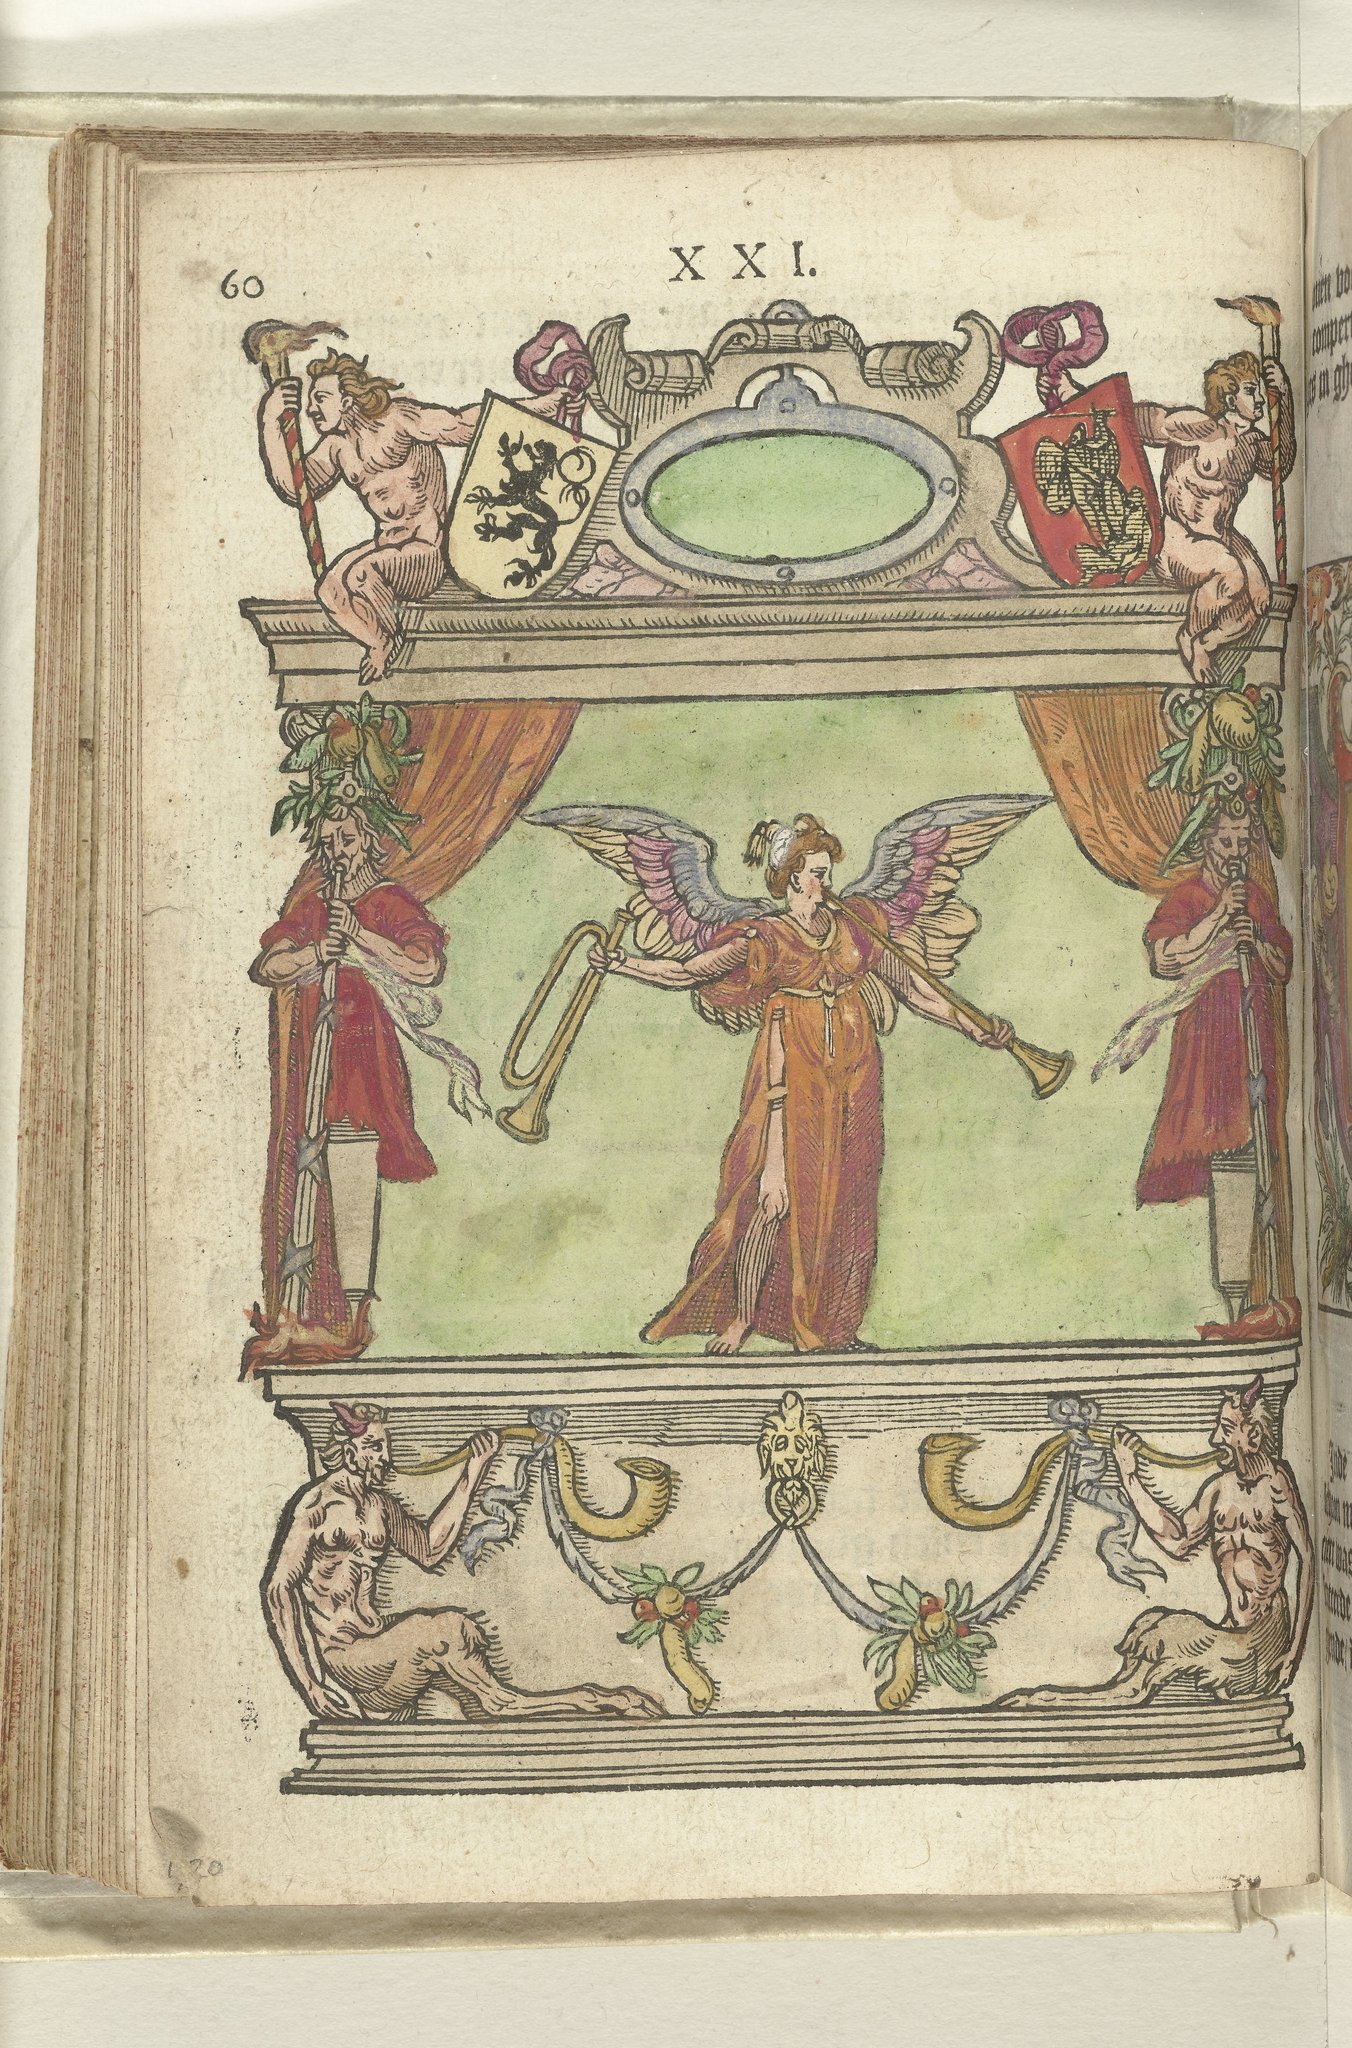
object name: print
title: Toneel met de personificatie van Faam (Fama), 1578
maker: antoni van leest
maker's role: print maker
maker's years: 1545-1592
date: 1578-1579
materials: paper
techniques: hand coloring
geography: antwerp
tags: vienna, matthias van oostenrijk (rooms-duits keizer), group of actors, troupe; actors on the stage, triumphal entry and public reception, pageant, 'entrée solennelle', 'joyeuse entrée', fame; 'fama', 'fama buona', 'fama chiara' (ripa), brussels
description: Illustratie in: J.B. Houwaert, Sommare beschrijvinghe vade triumphelijcke Incomst van den doorluchtighen ende hooghgheboren /Aerts-hertoge Matthias binnen die Prinelijcke stadt van Brussele, in 't iaer ons Heeren 1578 den XVIII dach Januarij... Gheinventeert ende ghecomponeert deur Jean Baptista Houwaert, Christoffel Plantijn, Antwerpen 1579. Boek in de Rijksmuseum Research Library met signatuur: 327 K 2.